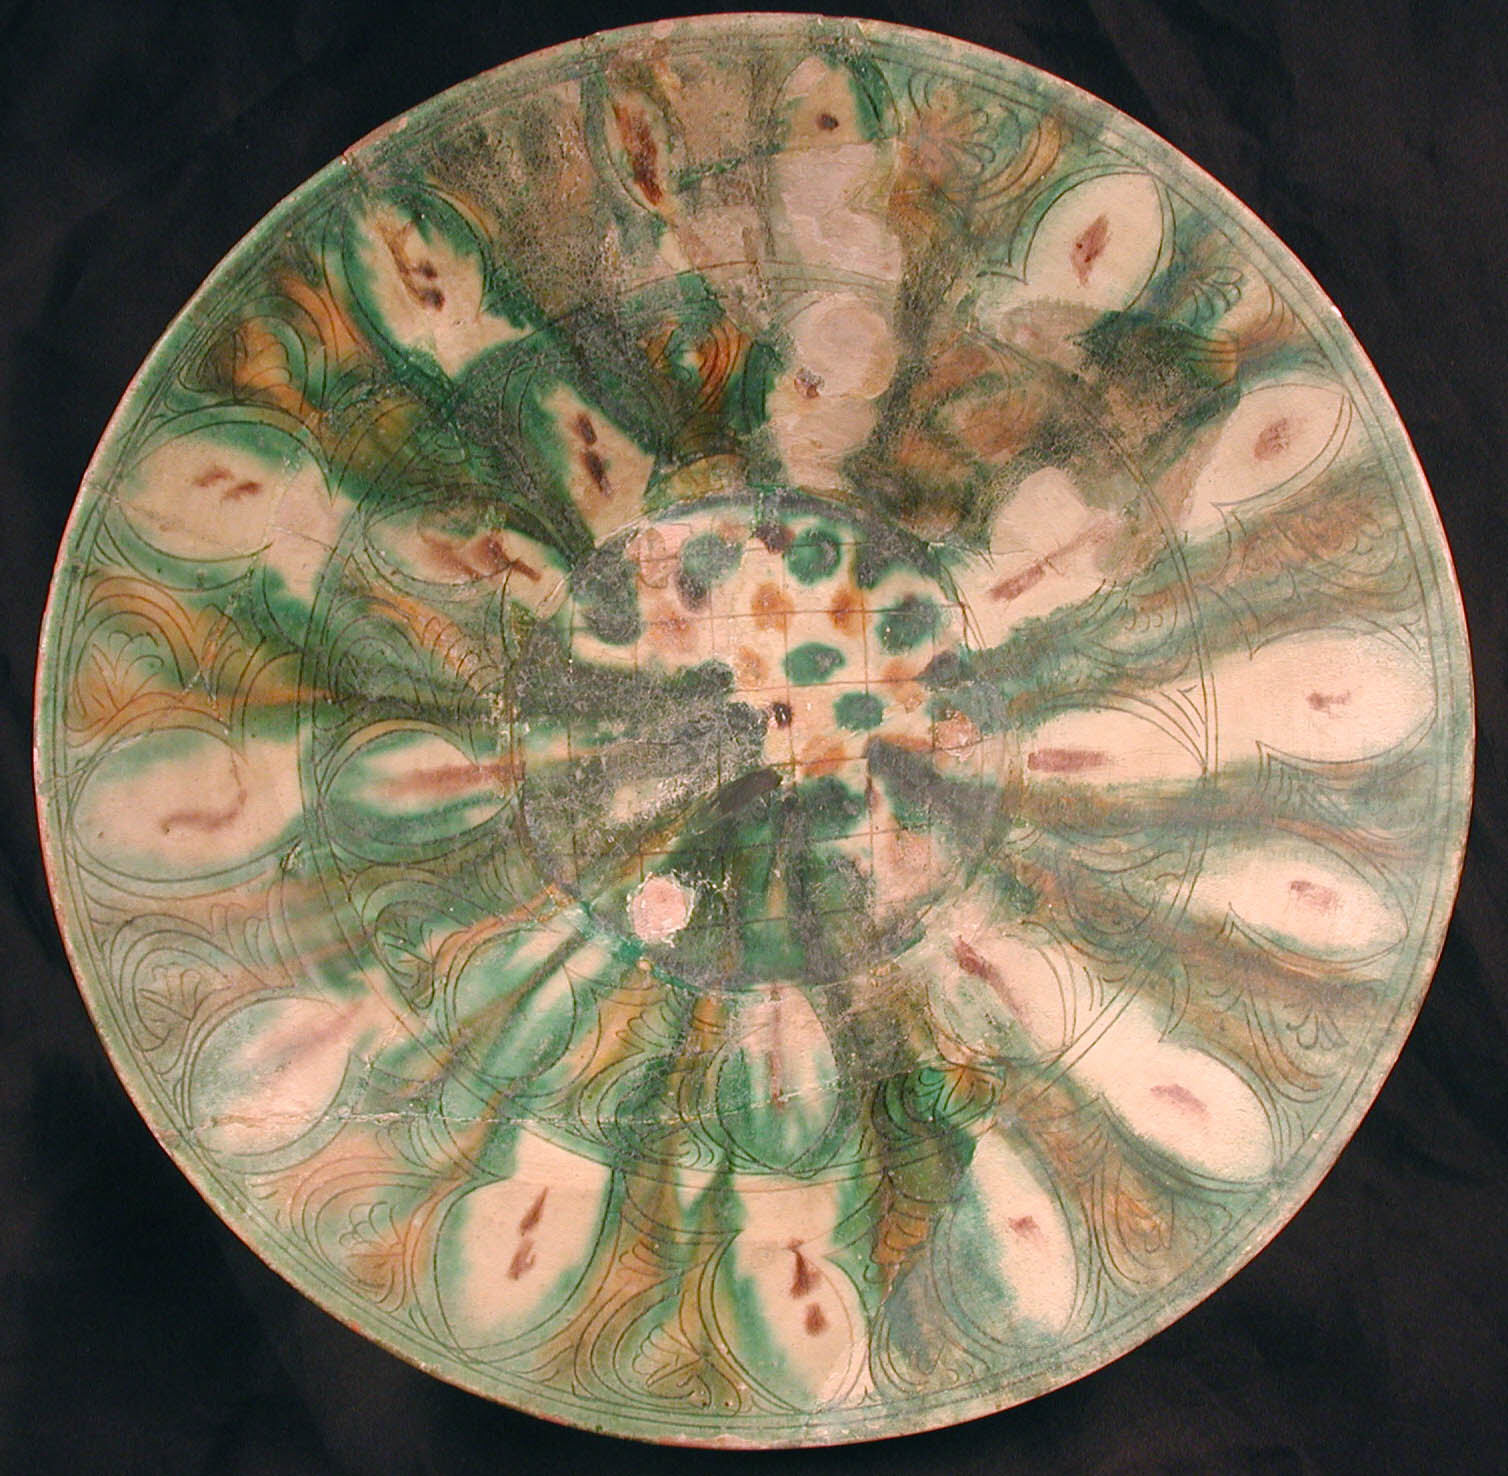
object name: bowl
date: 801-1000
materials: earthenware, glaze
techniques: incising, polychrome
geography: iran